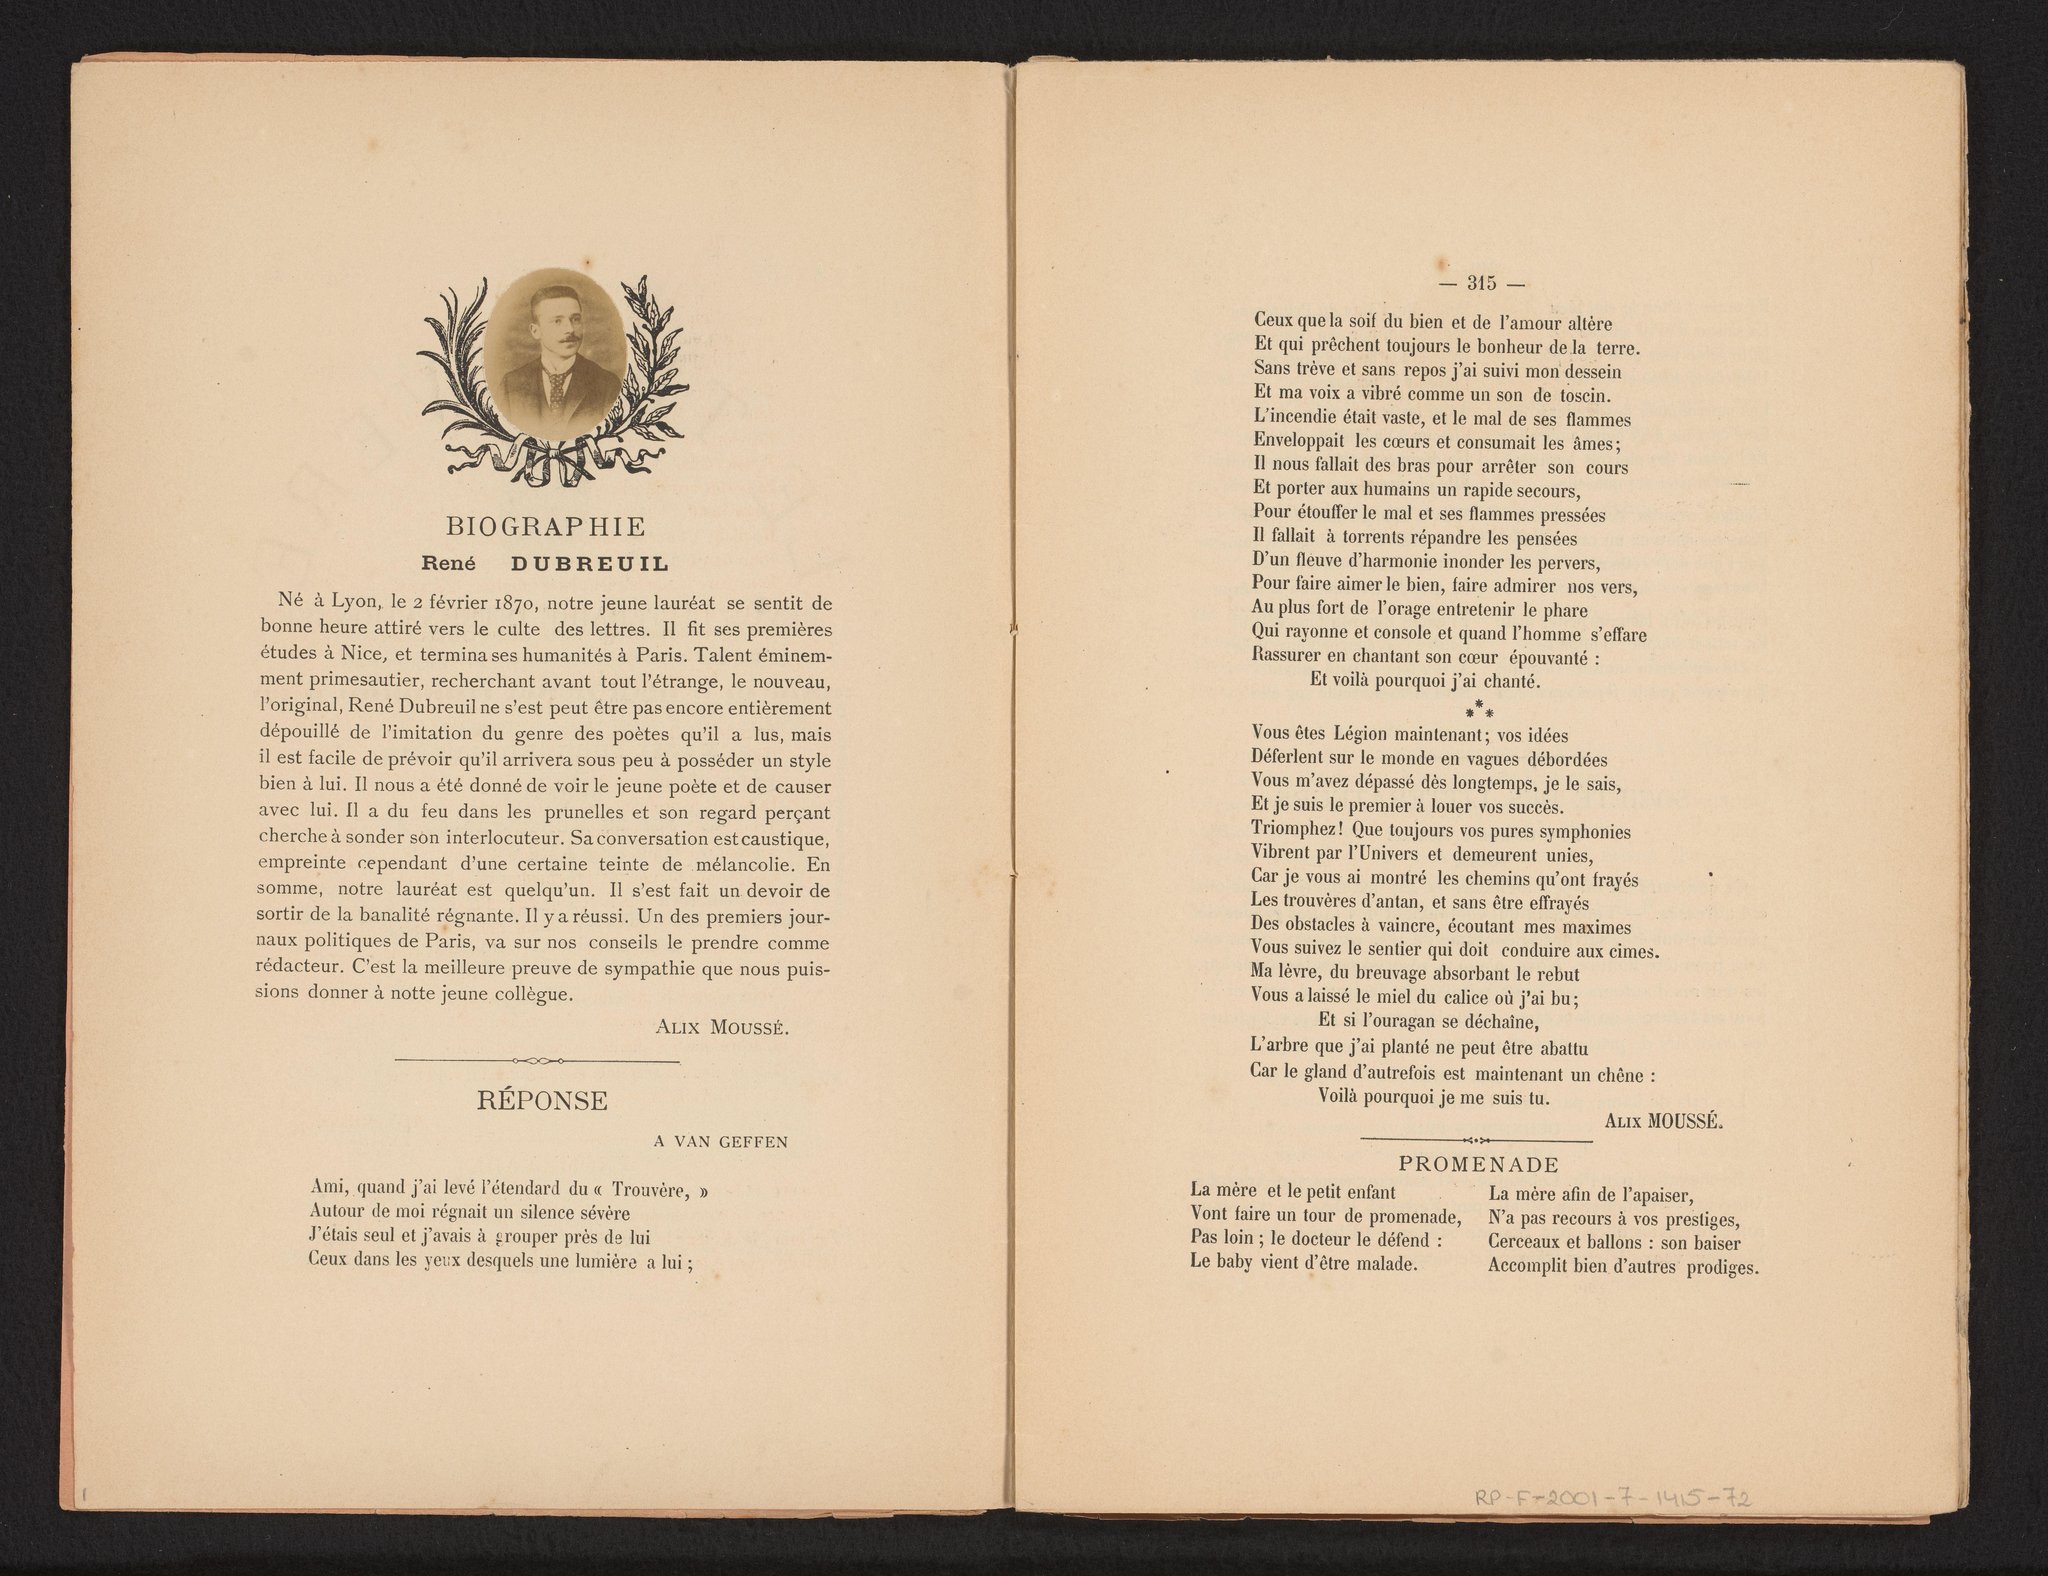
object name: page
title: Portret van René Dubreuil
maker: Anonymous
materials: photographic support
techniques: albumen print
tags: lyon, historical persons